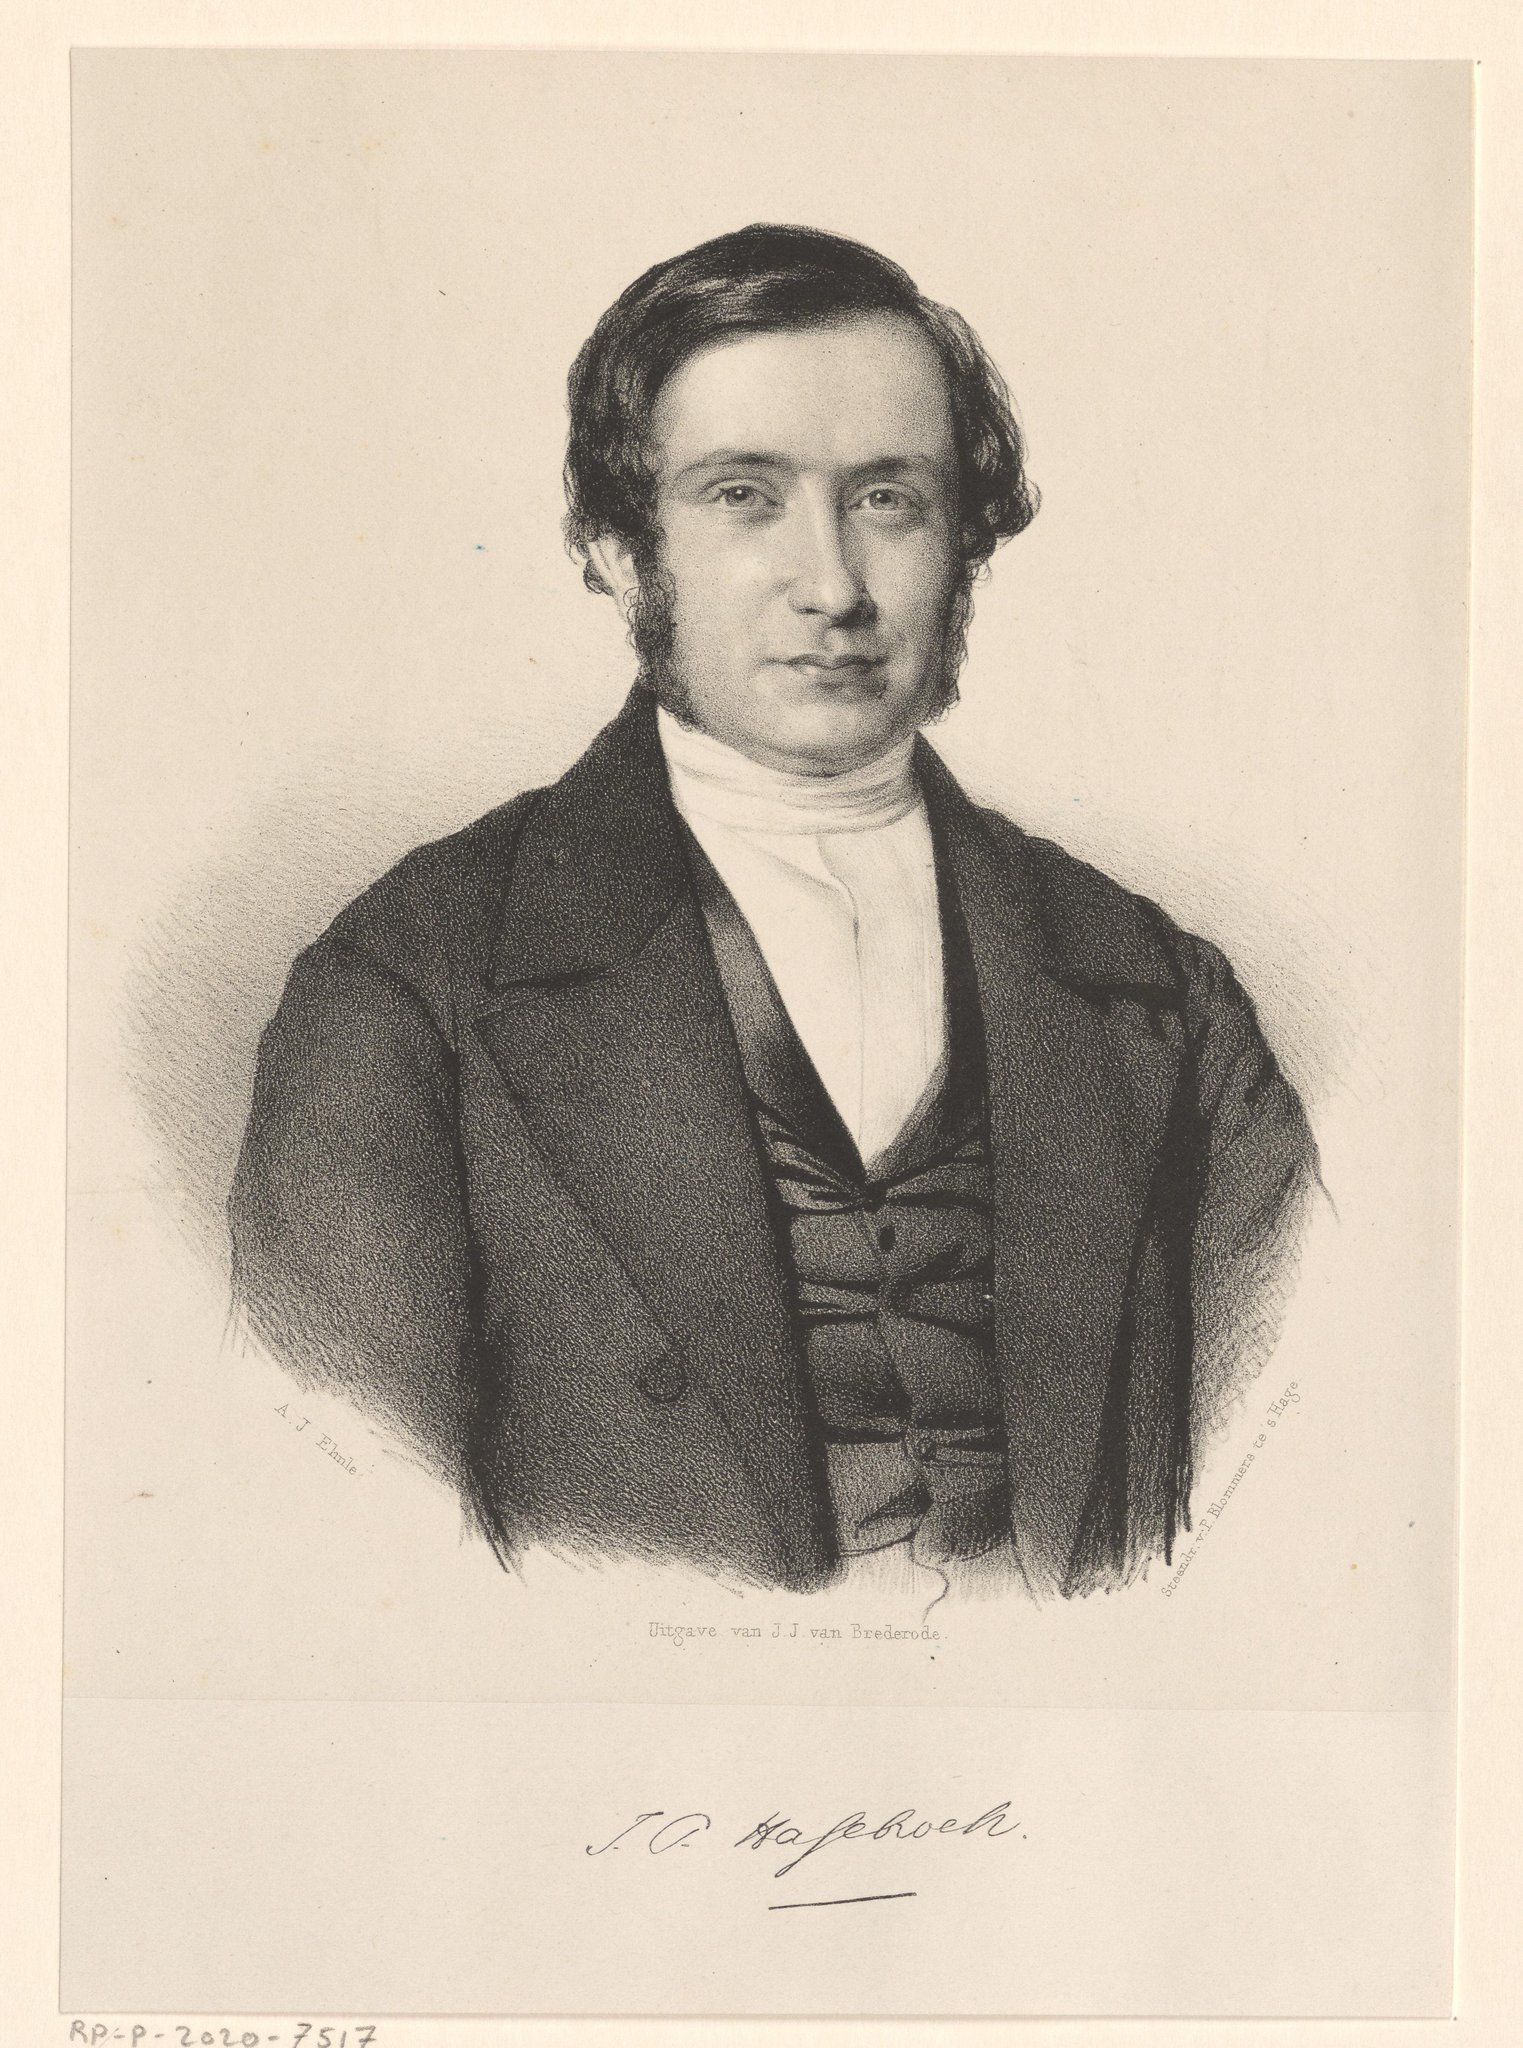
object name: print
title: Portret van Johannes Petrus Hasebroek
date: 1847-1853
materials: paper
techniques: lithograph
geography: haarlem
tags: leiden, amsterdam, historical persons, portrait of a writer